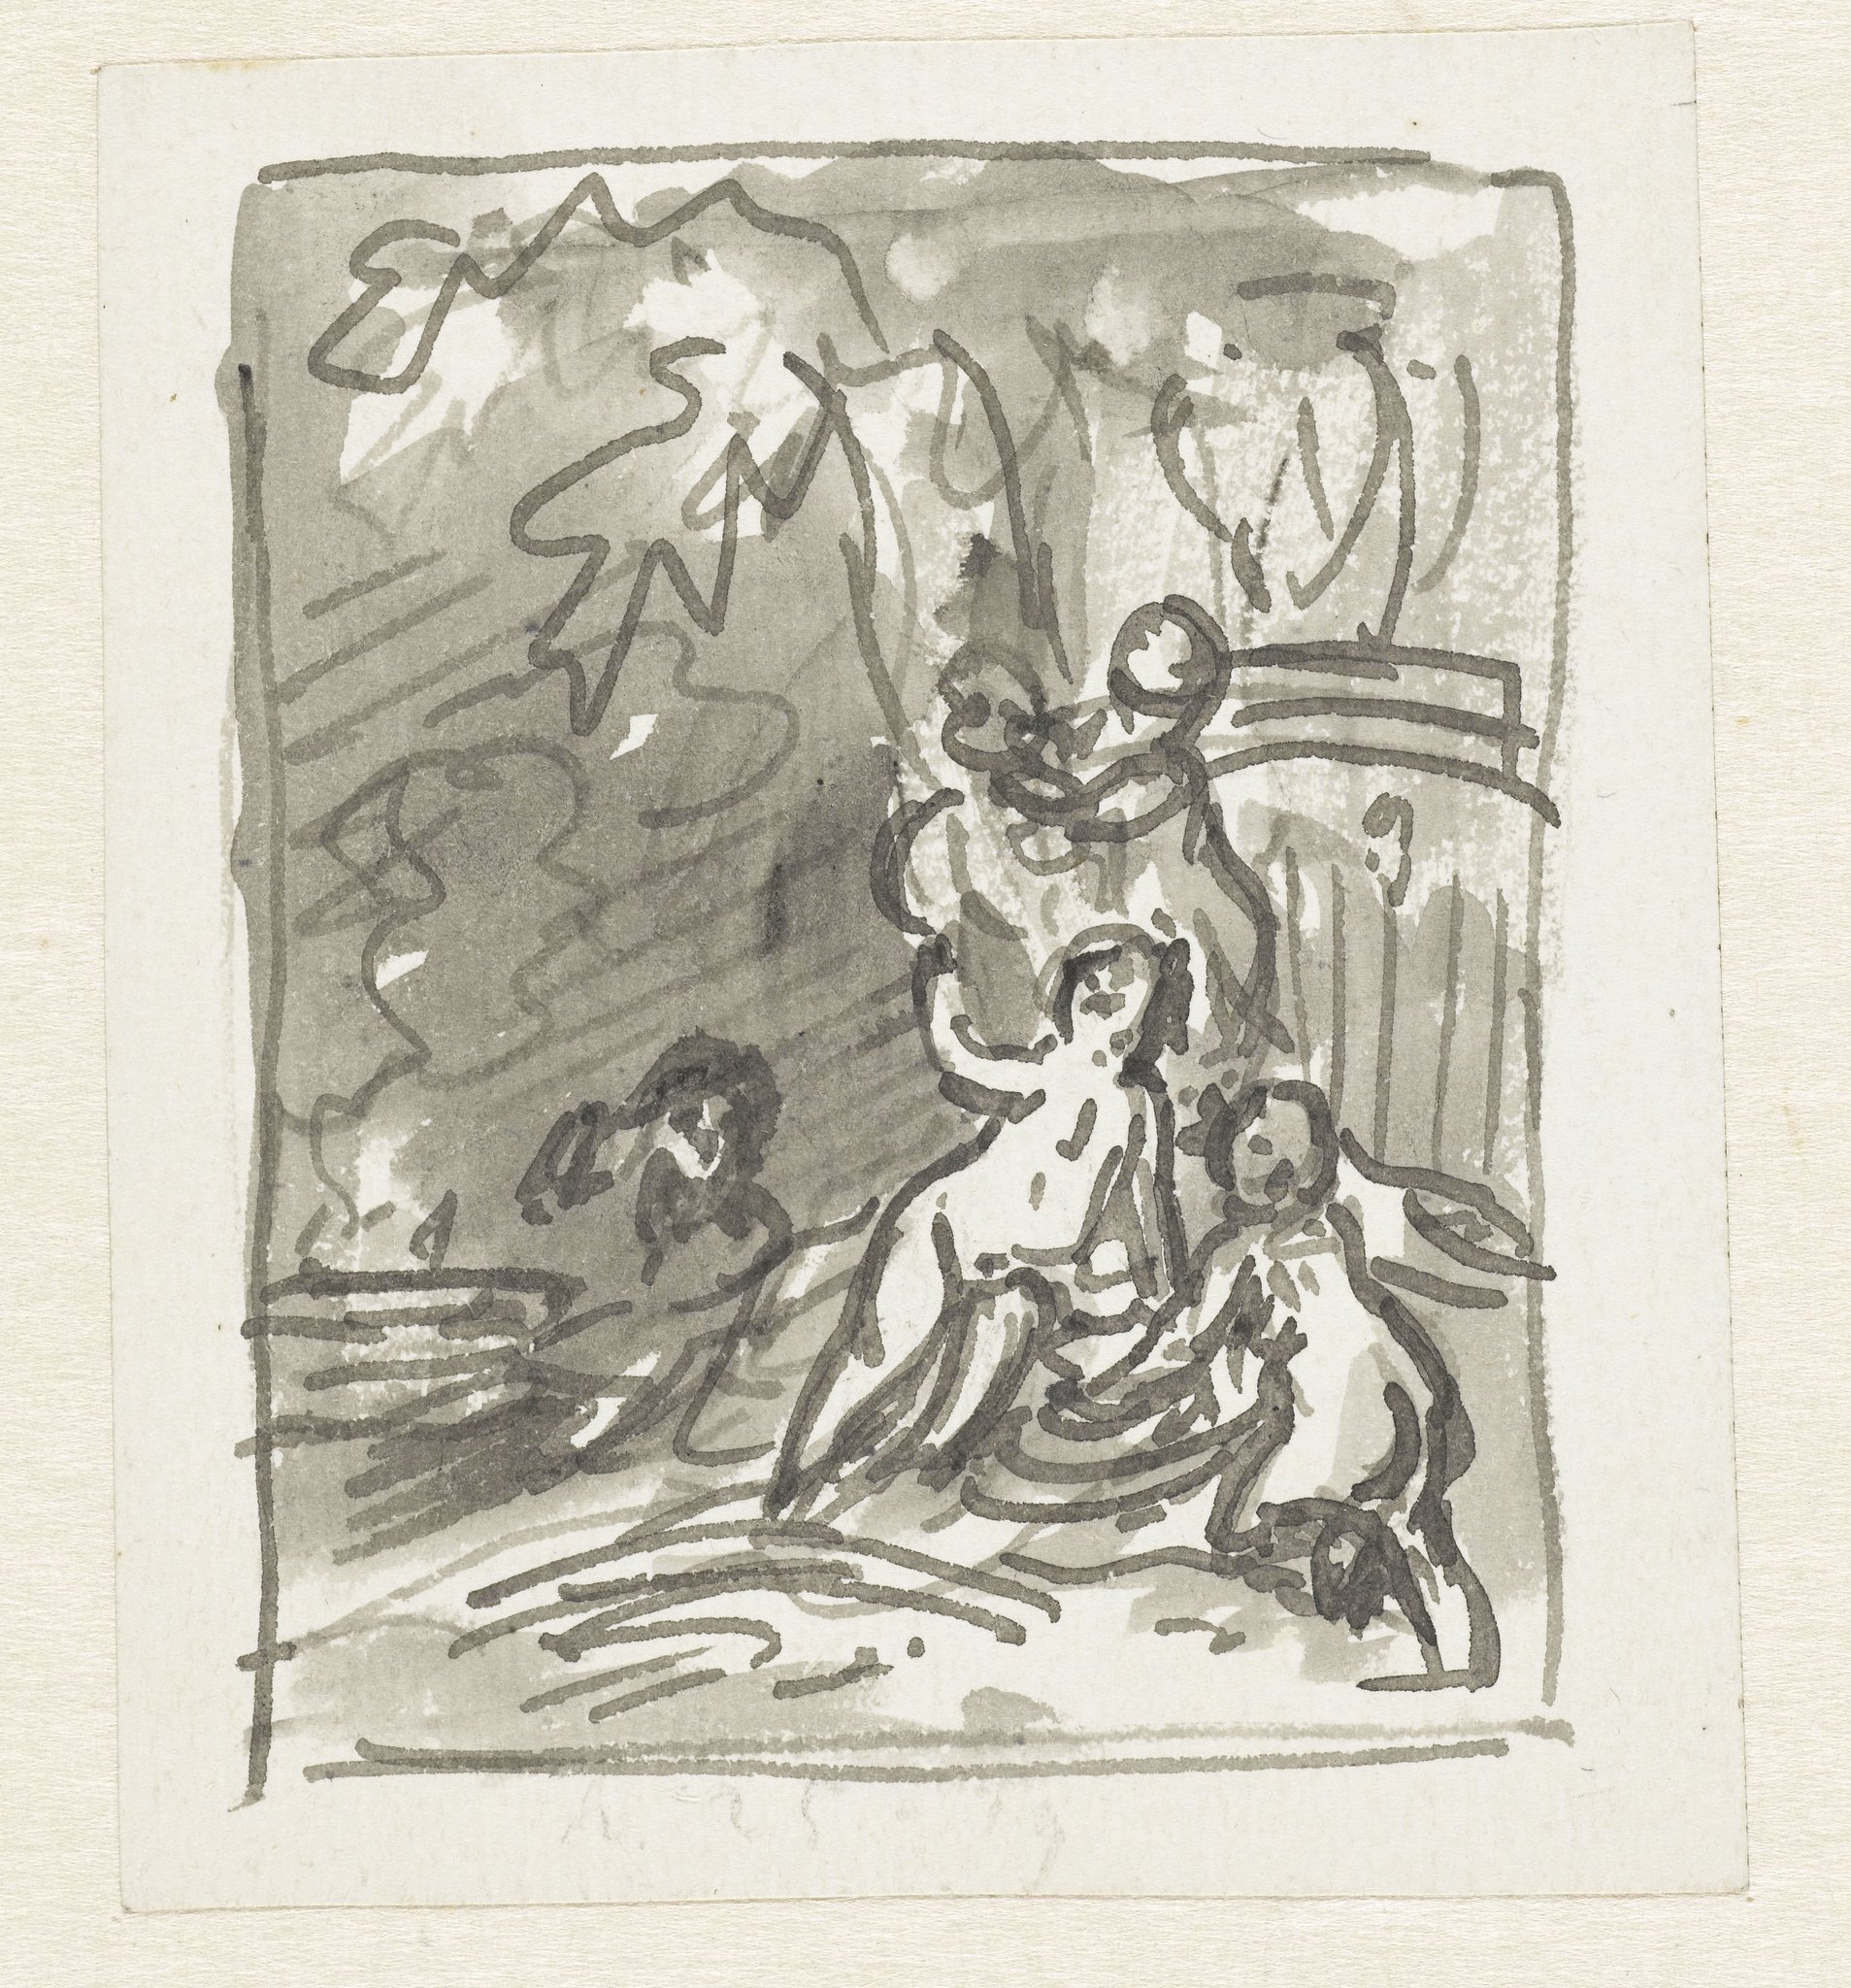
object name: drawing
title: Vier putti onder een boom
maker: jurriaan andriessen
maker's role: draughtsman, painter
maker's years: 1742-1819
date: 1798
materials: graphite, ink, paper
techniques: brush, pen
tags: drawing, sketch, picture, painting